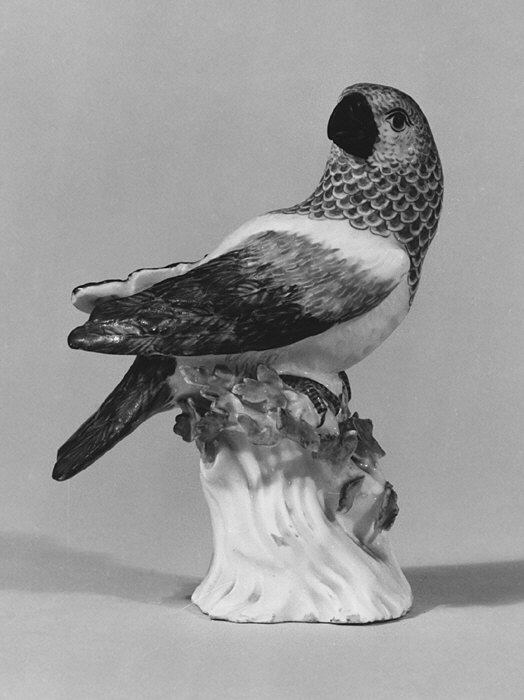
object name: figure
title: Parrot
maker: meissen manufactory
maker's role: manufactory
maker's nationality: german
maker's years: 1710-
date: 1741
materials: hard paste porcelain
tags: parrots